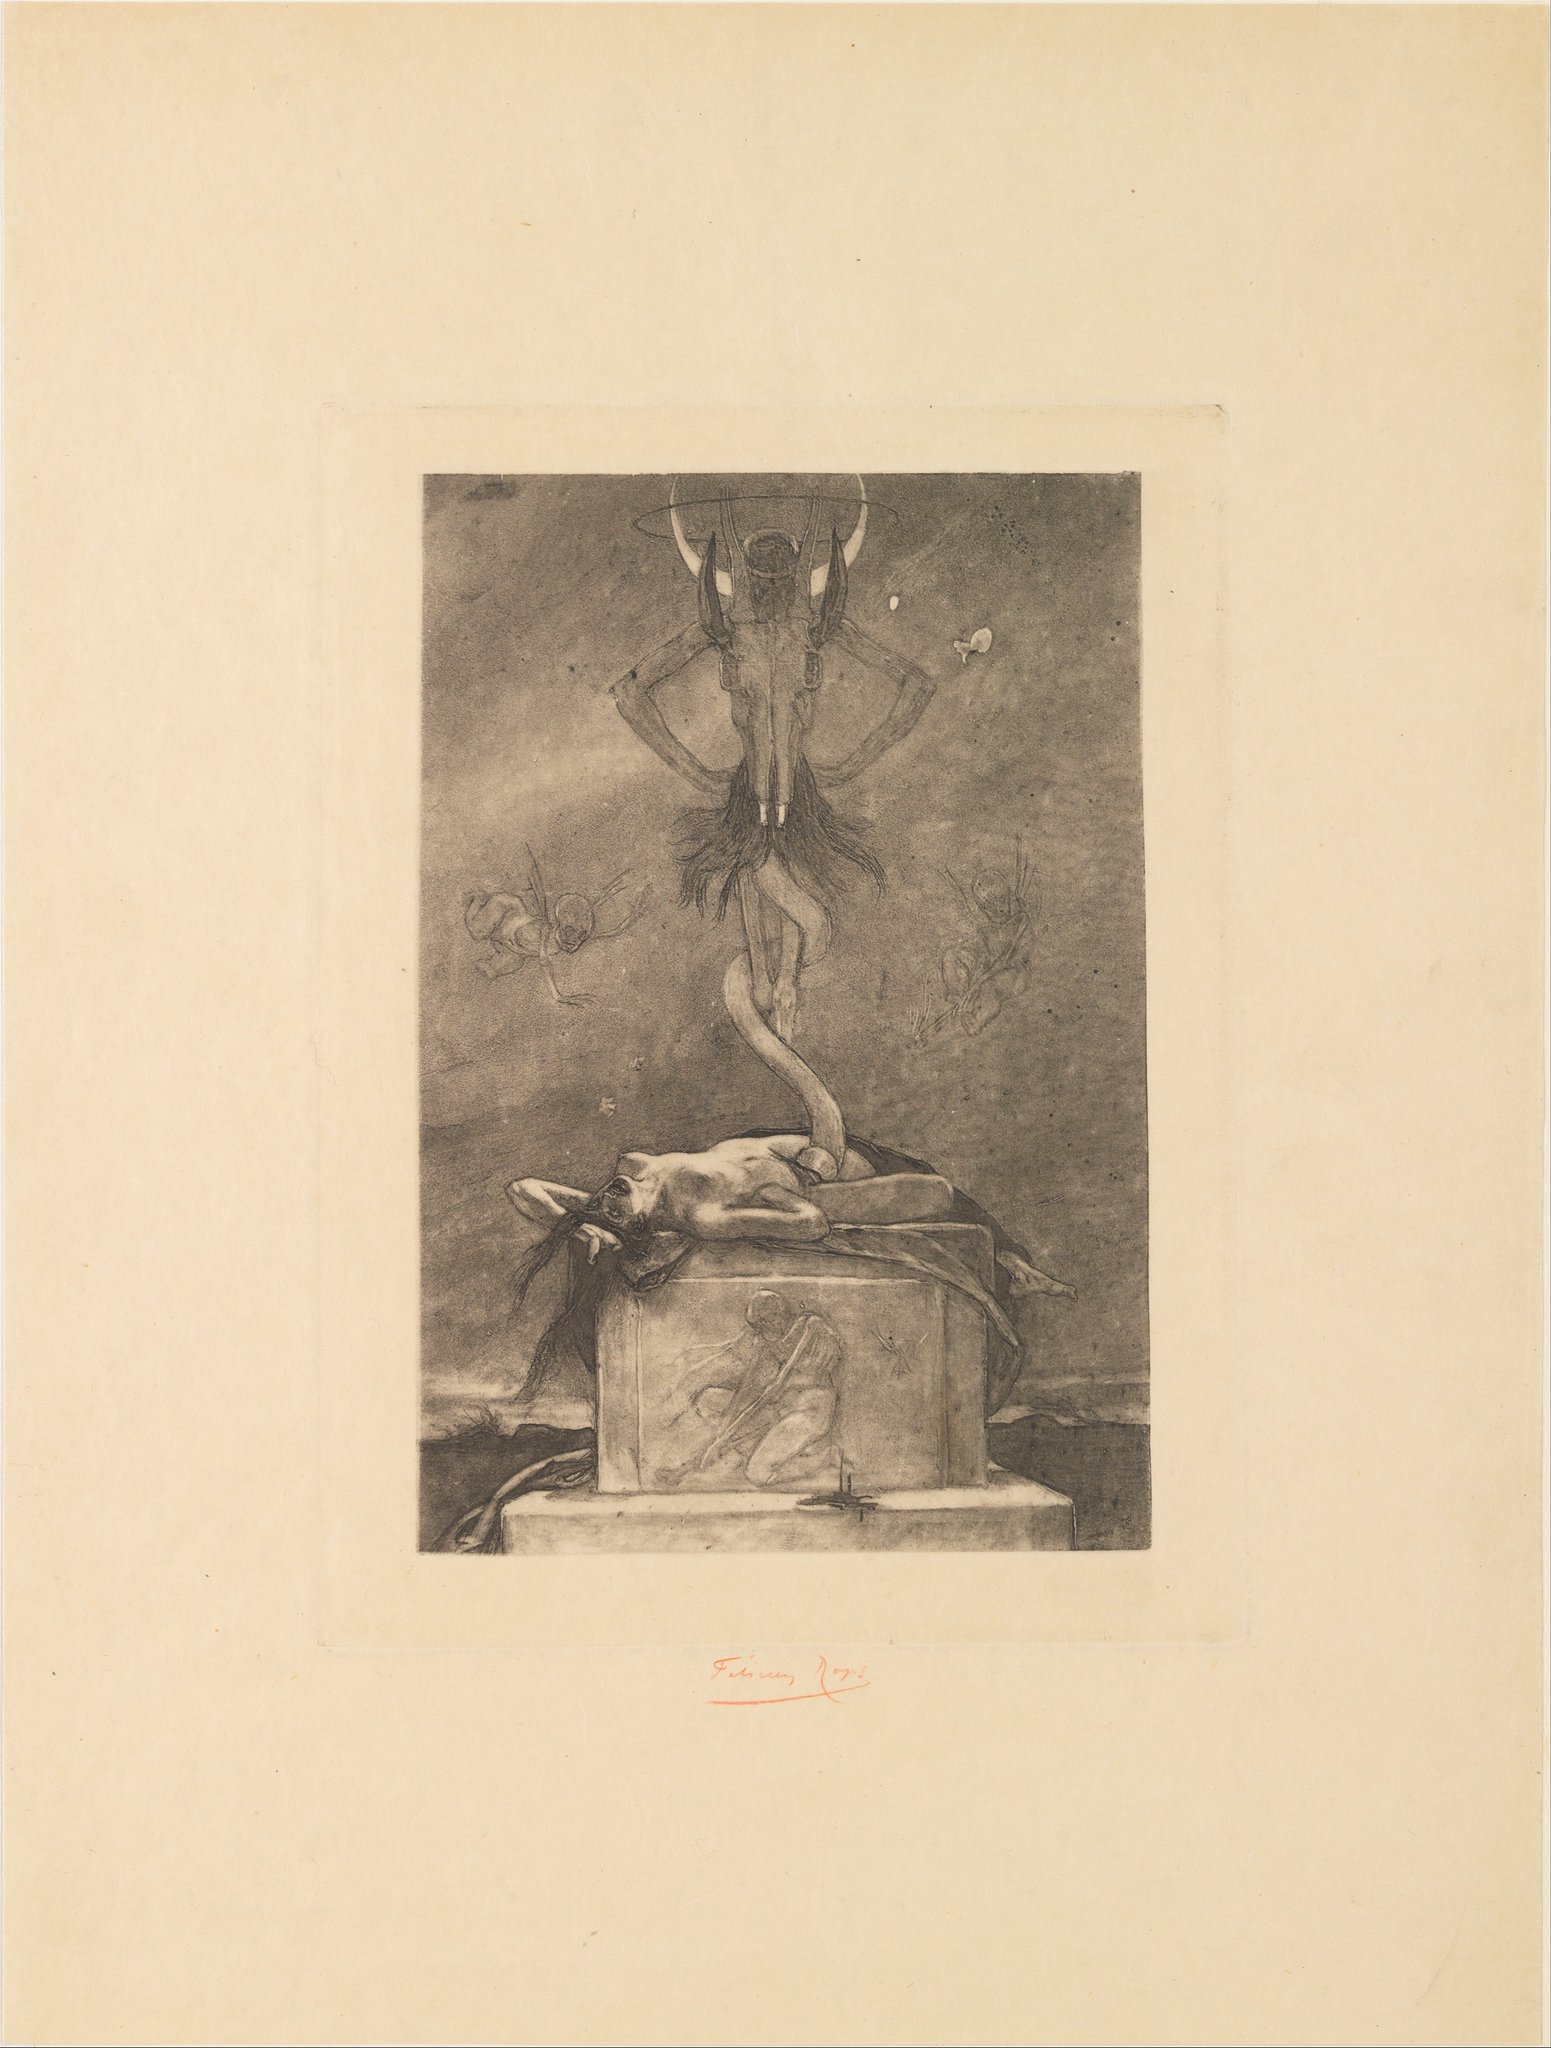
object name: print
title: The Sacrifice, from "The Satanic Ones"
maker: félicien rops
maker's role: artist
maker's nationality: belgian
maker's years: 1833-1898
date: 1882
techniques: etching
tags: female nudes